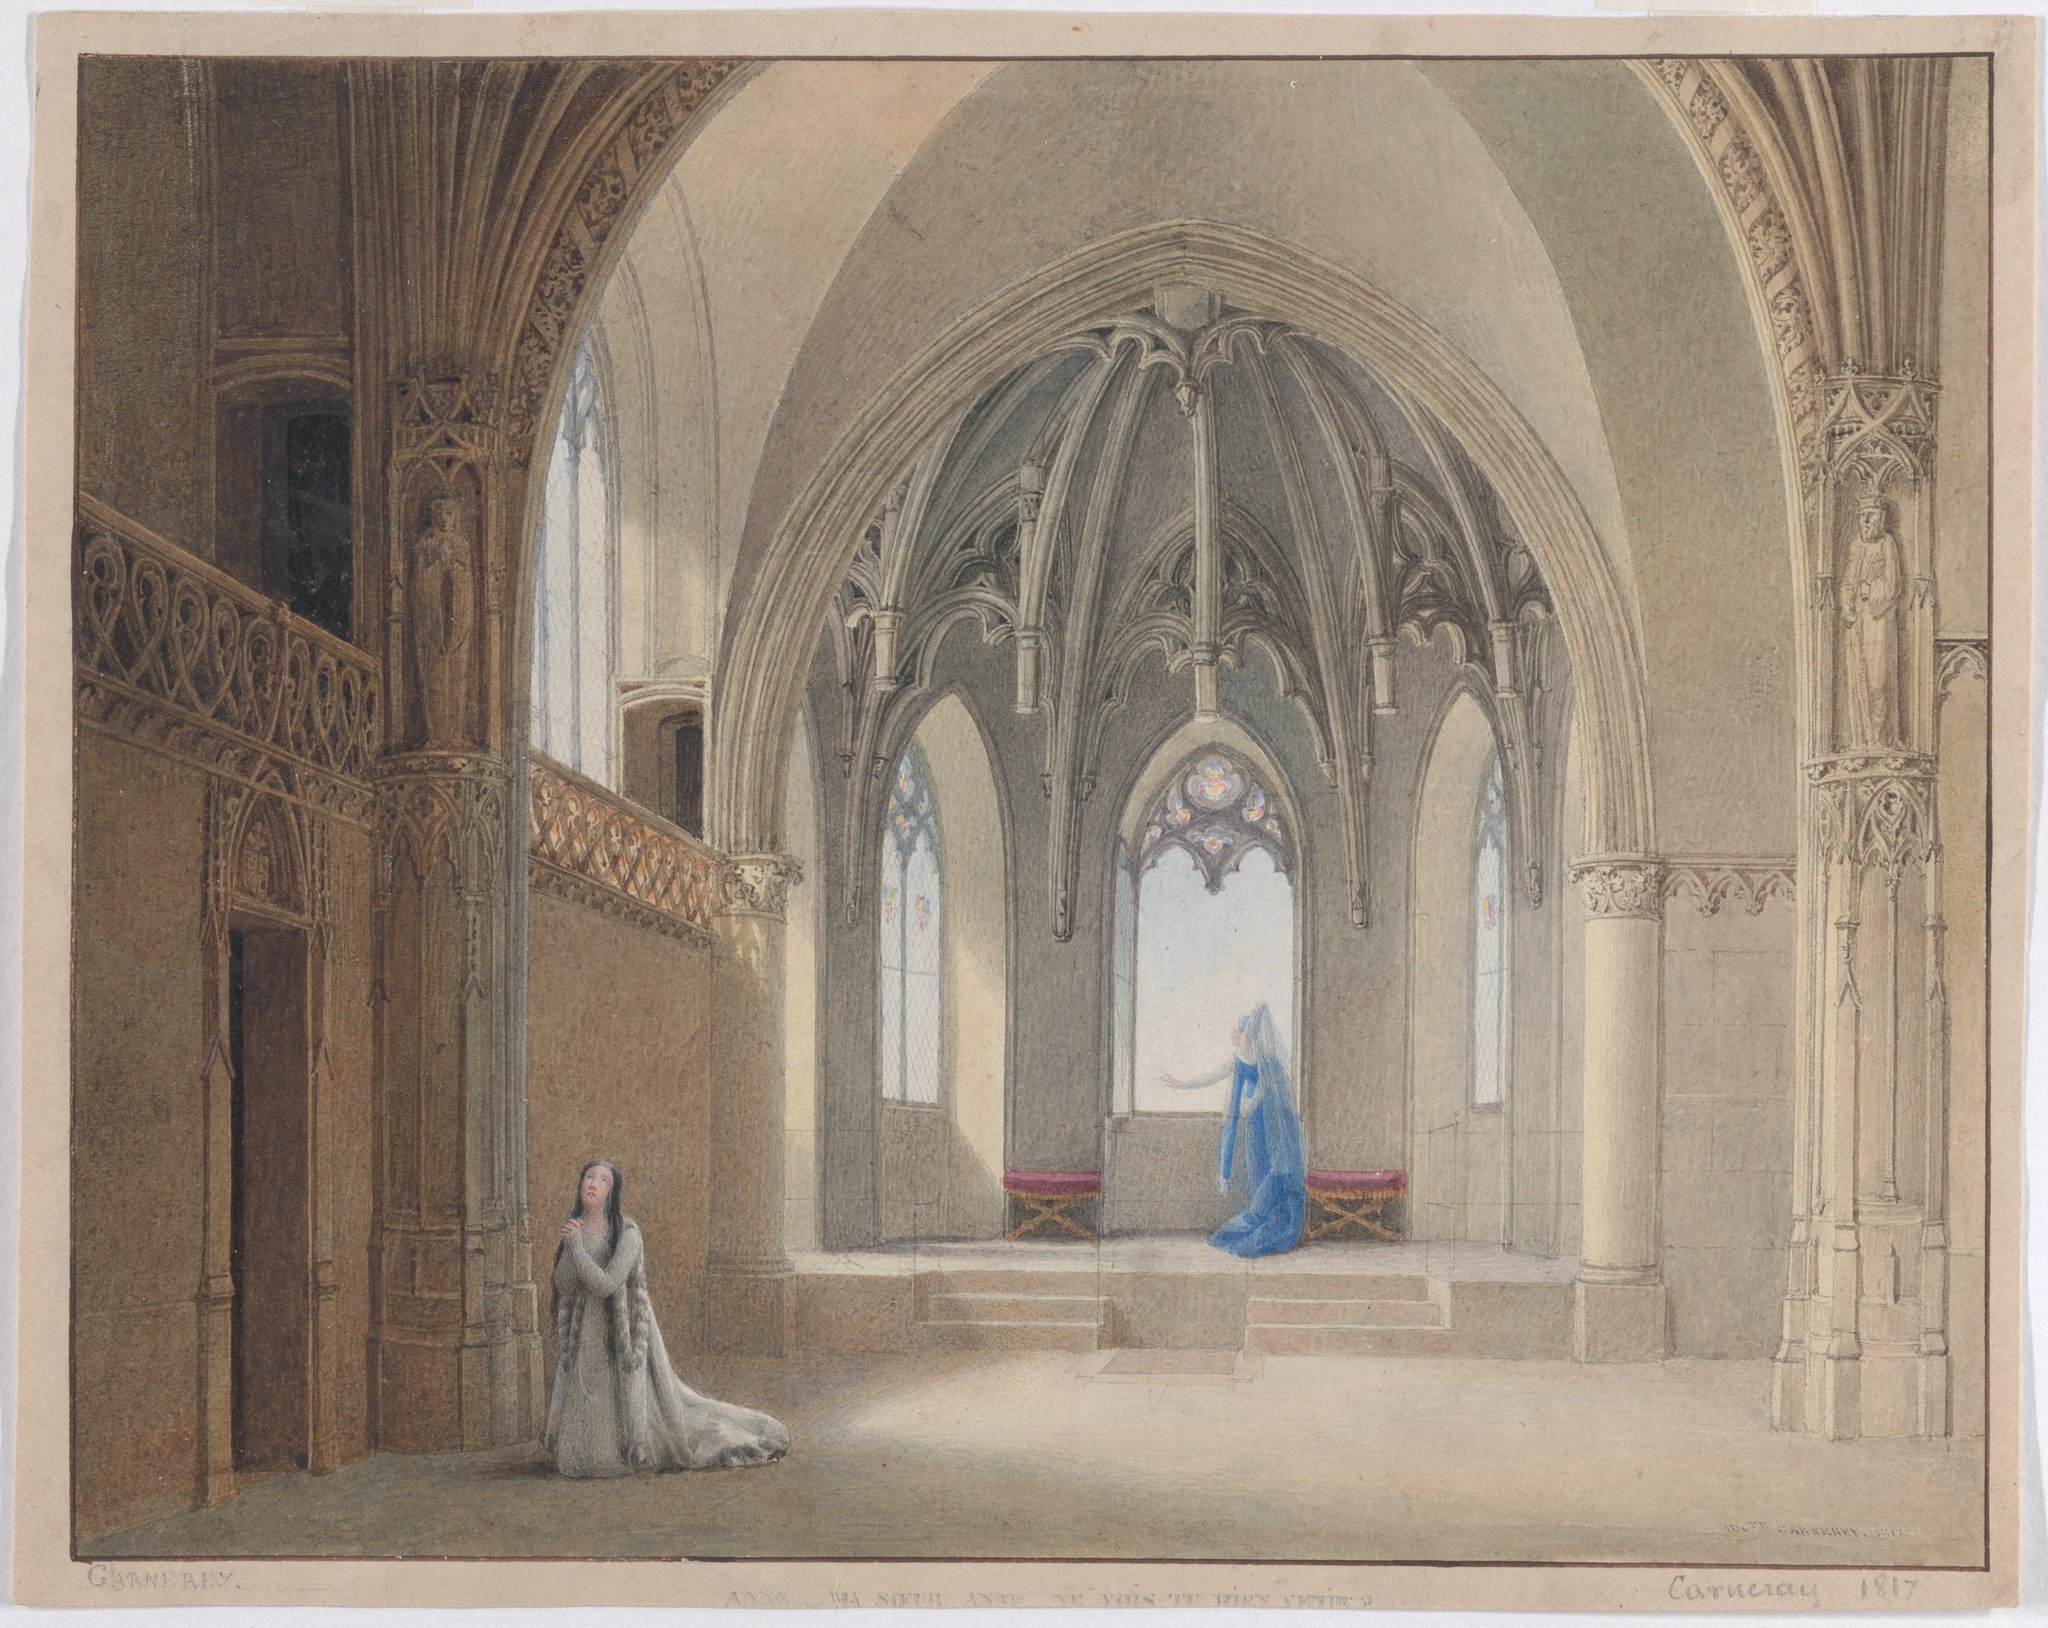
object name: drawing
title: Anne, ma soeur Anne, ne vois-tu rien venir?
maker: auguste garneray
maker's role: artist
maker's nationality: french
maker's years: 1785-1824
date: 1817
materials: watercolor